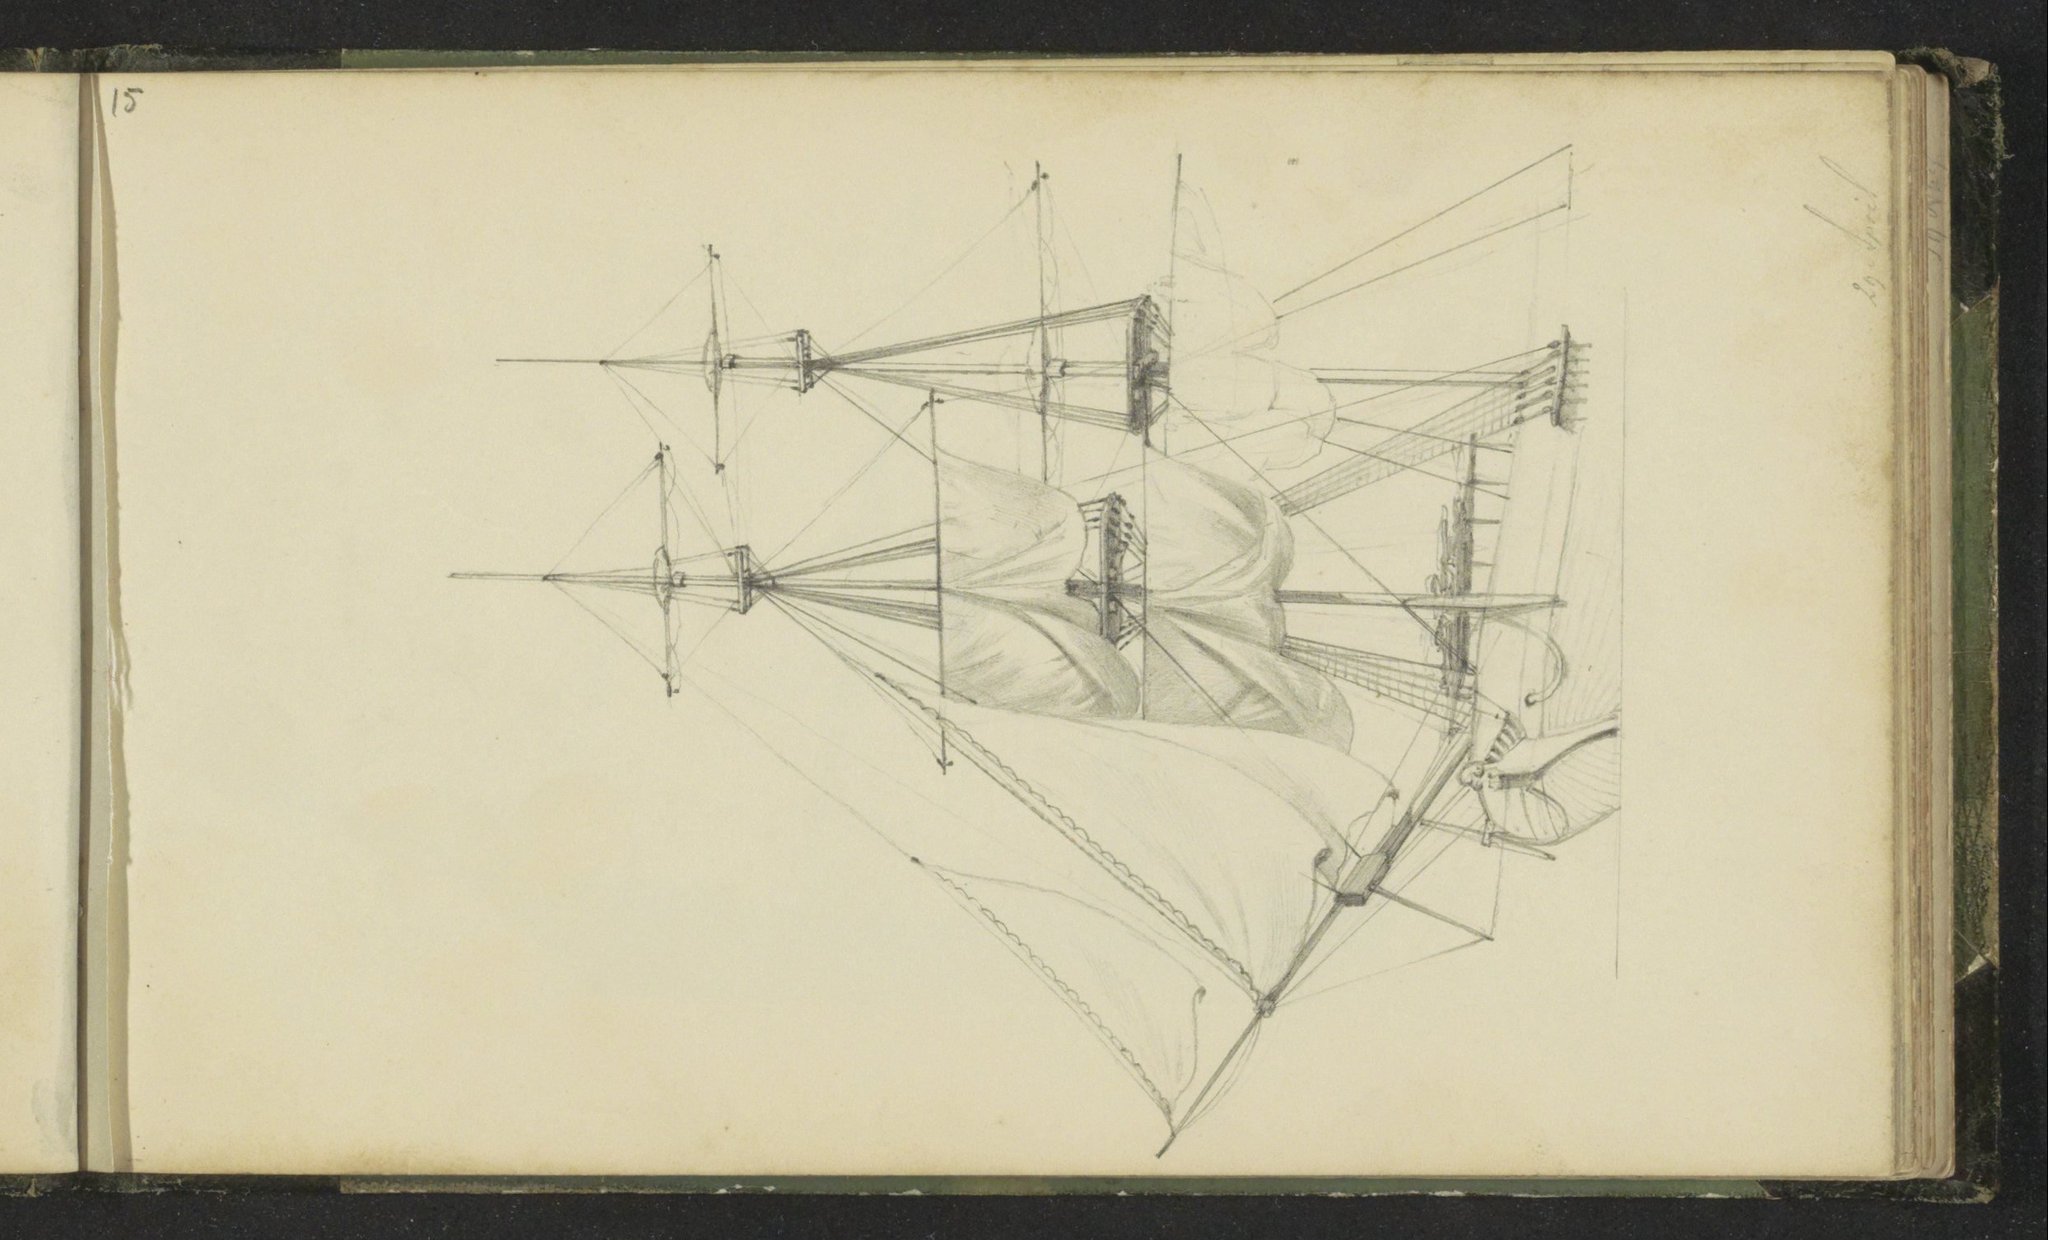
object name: sketchbook leaf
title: Tweemaster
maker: hendrik abraham klinkhamer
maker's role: draughtsman, painter, print maker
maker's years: 1810-1872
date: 1804-1843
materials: paper, pencil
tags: sailing-ship, sailing-boat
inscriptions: date: ‘29 April’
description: Blad 15 recto uit een schetsboek met 40 bladen.